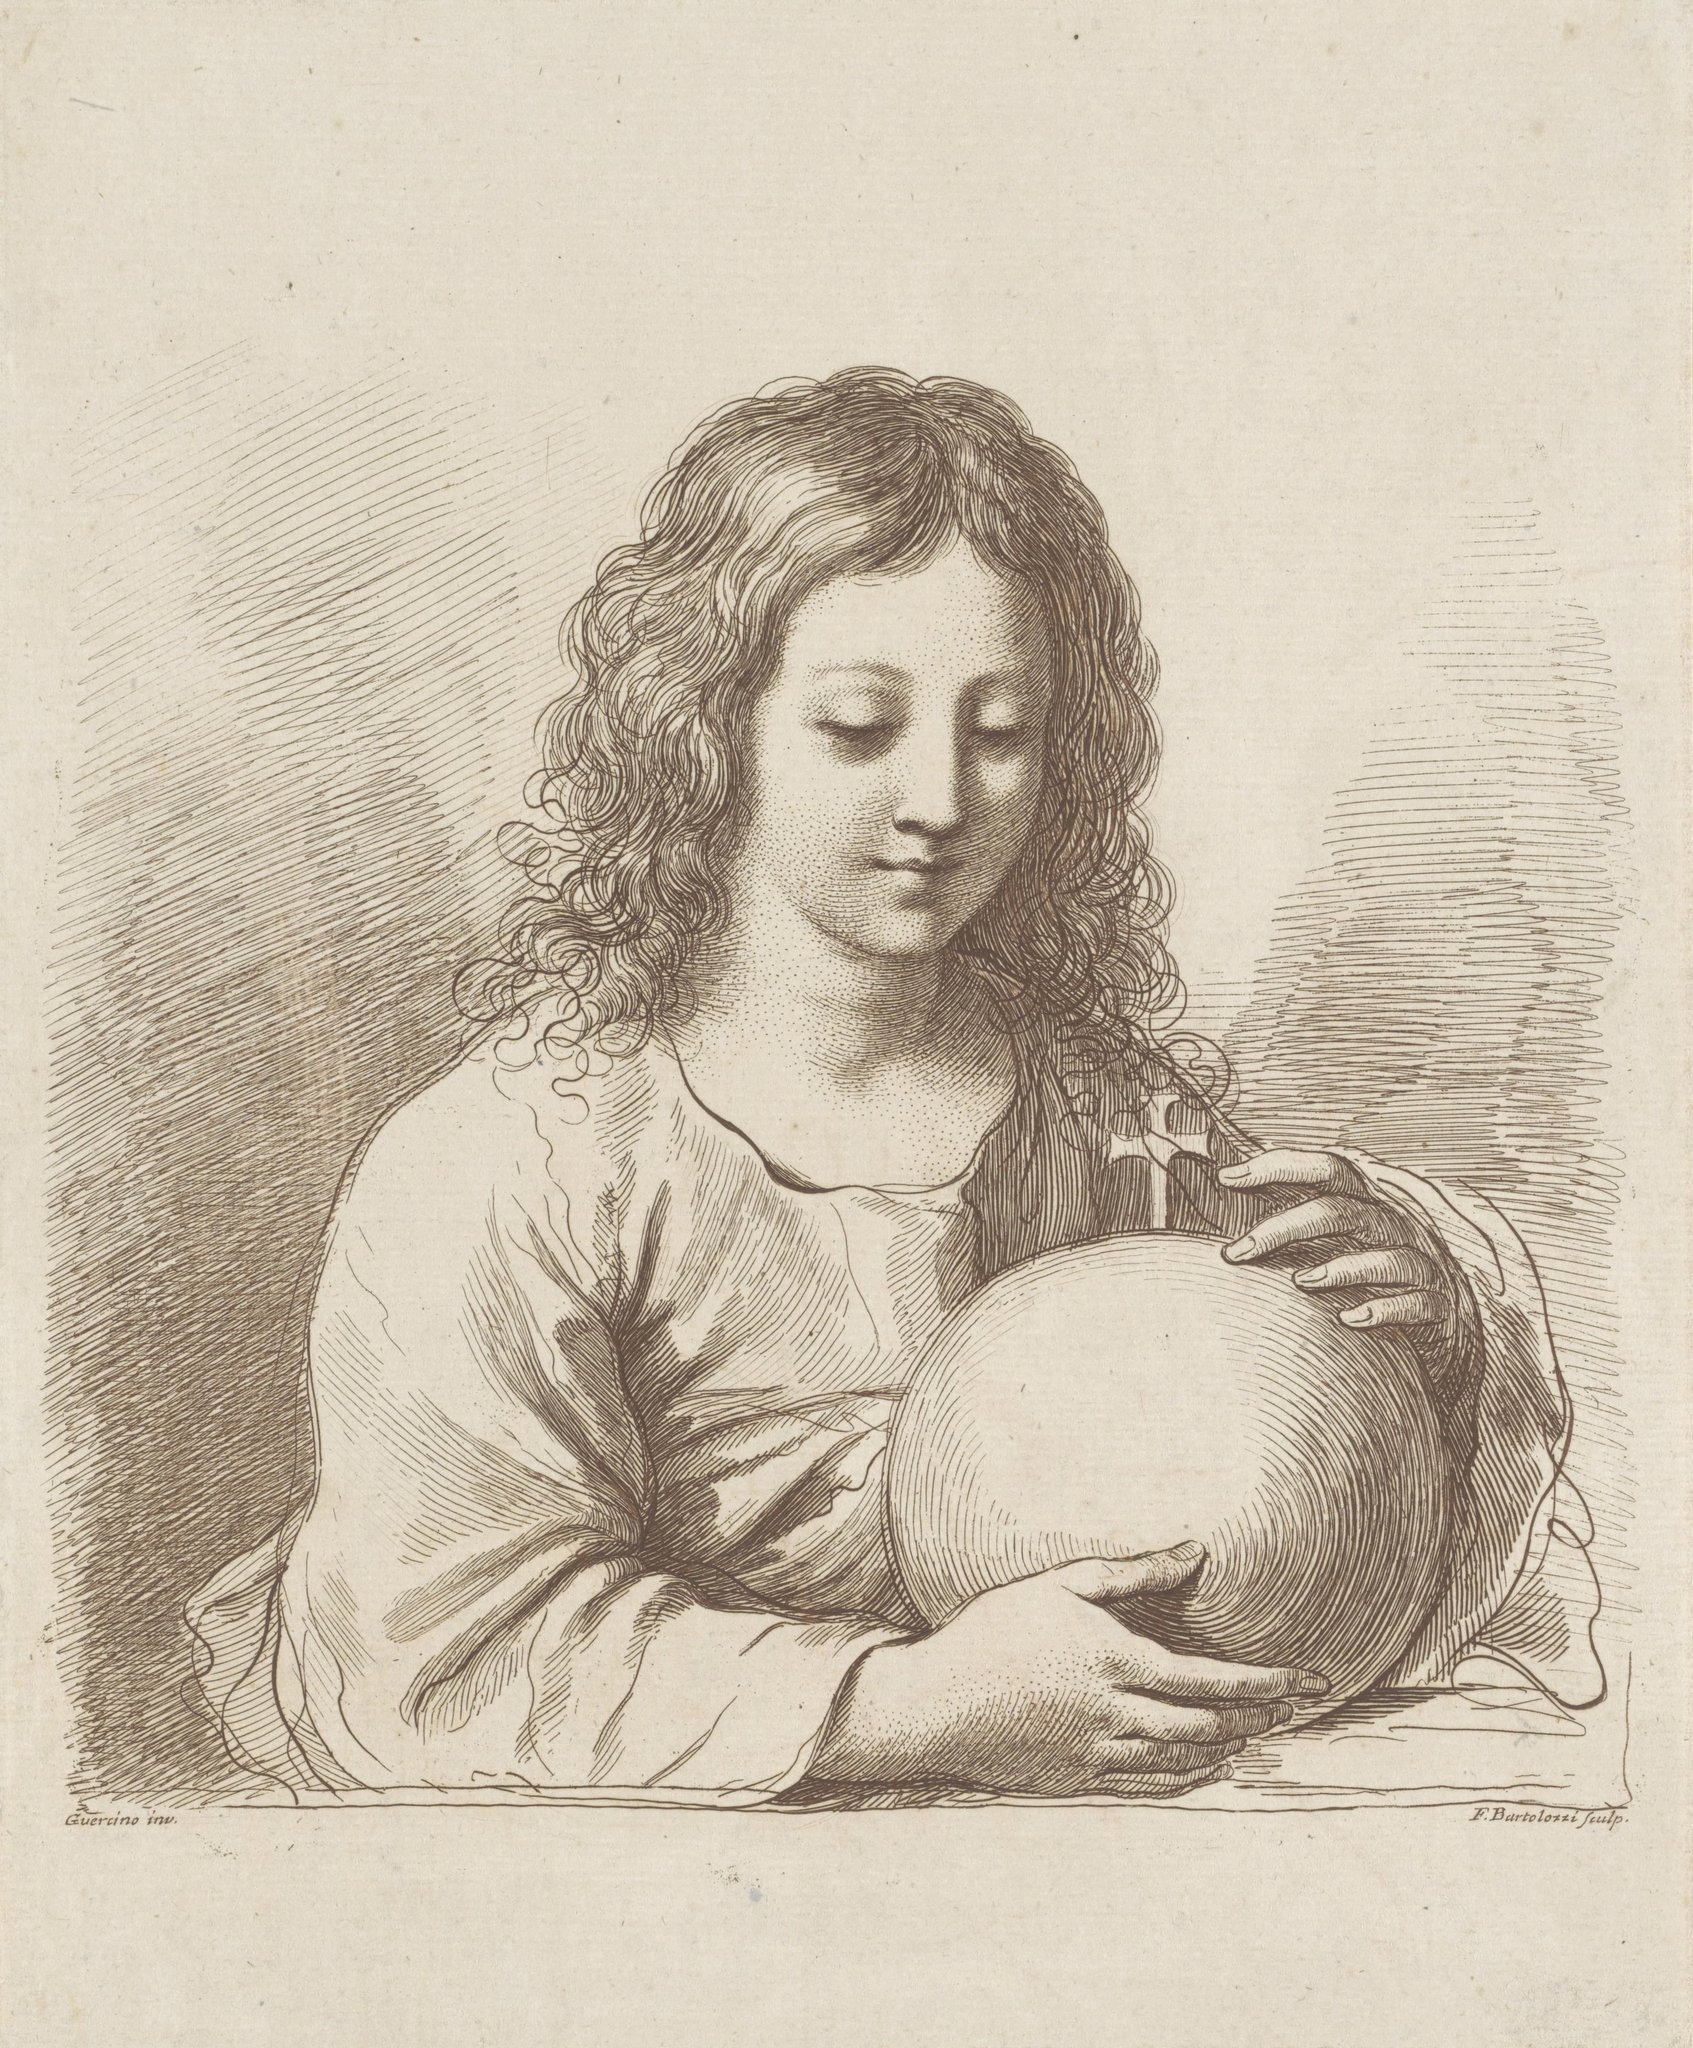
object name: print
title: Christus met globe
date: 1738-1815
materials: paper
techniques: etching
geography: italy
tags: christ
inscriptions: collector's mark: Lugt 2228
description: Christus ten halven lijve met een globe in zijn handen.